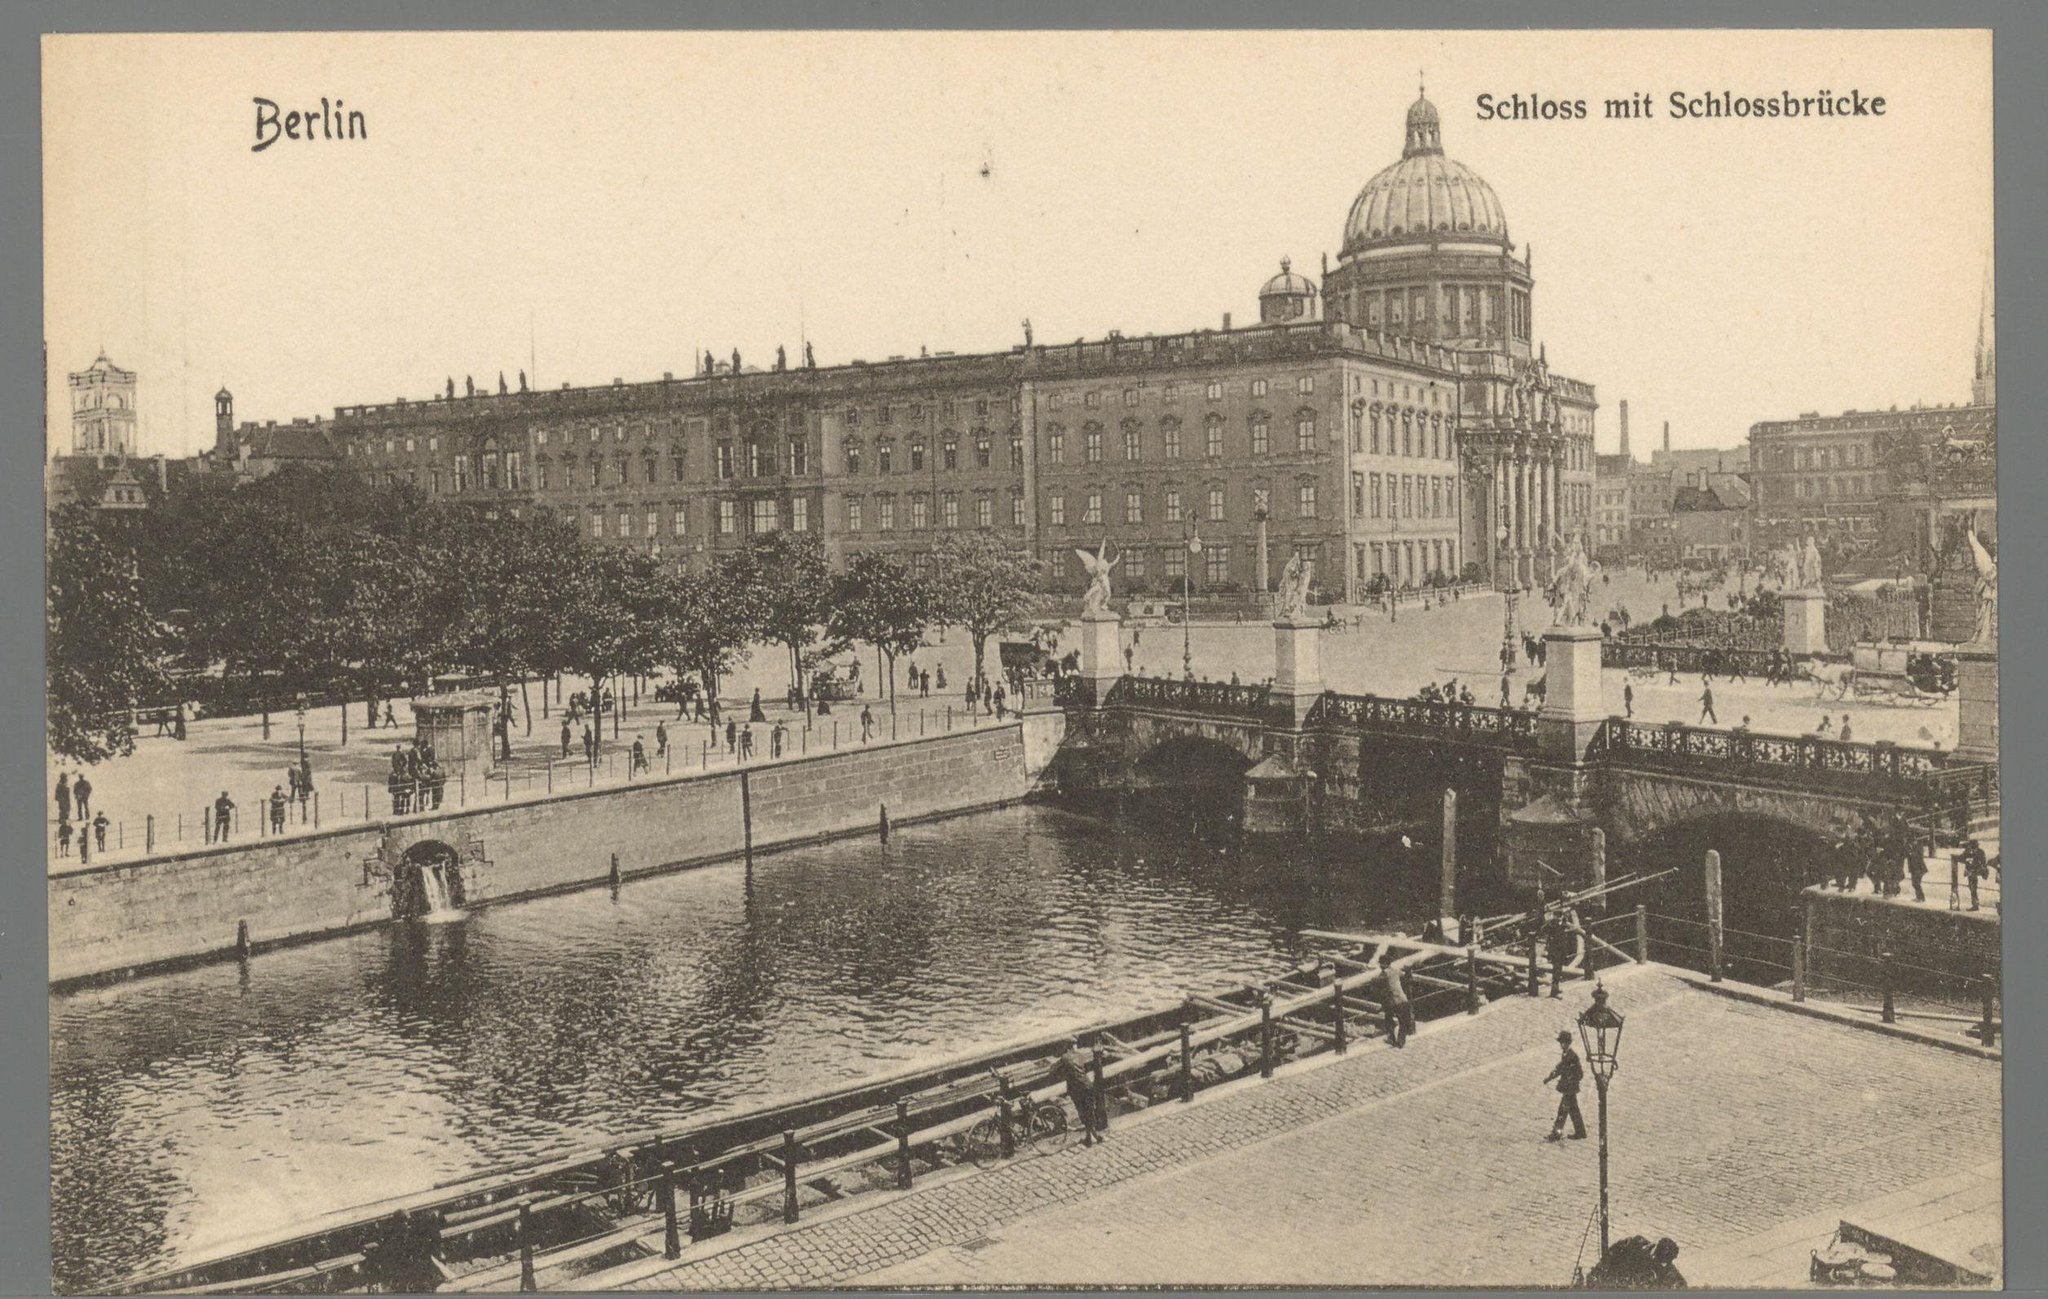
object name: photomechanical print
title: Berlin. Schloss mit Schlossbrücke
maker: Anonymous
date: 1905-1930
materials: cardboard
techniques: photograph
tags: castle, canals, waters (in city), bridge in city across river, canal, etc., berlin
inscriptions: stamp: ‘5’, monogram: ‘F’